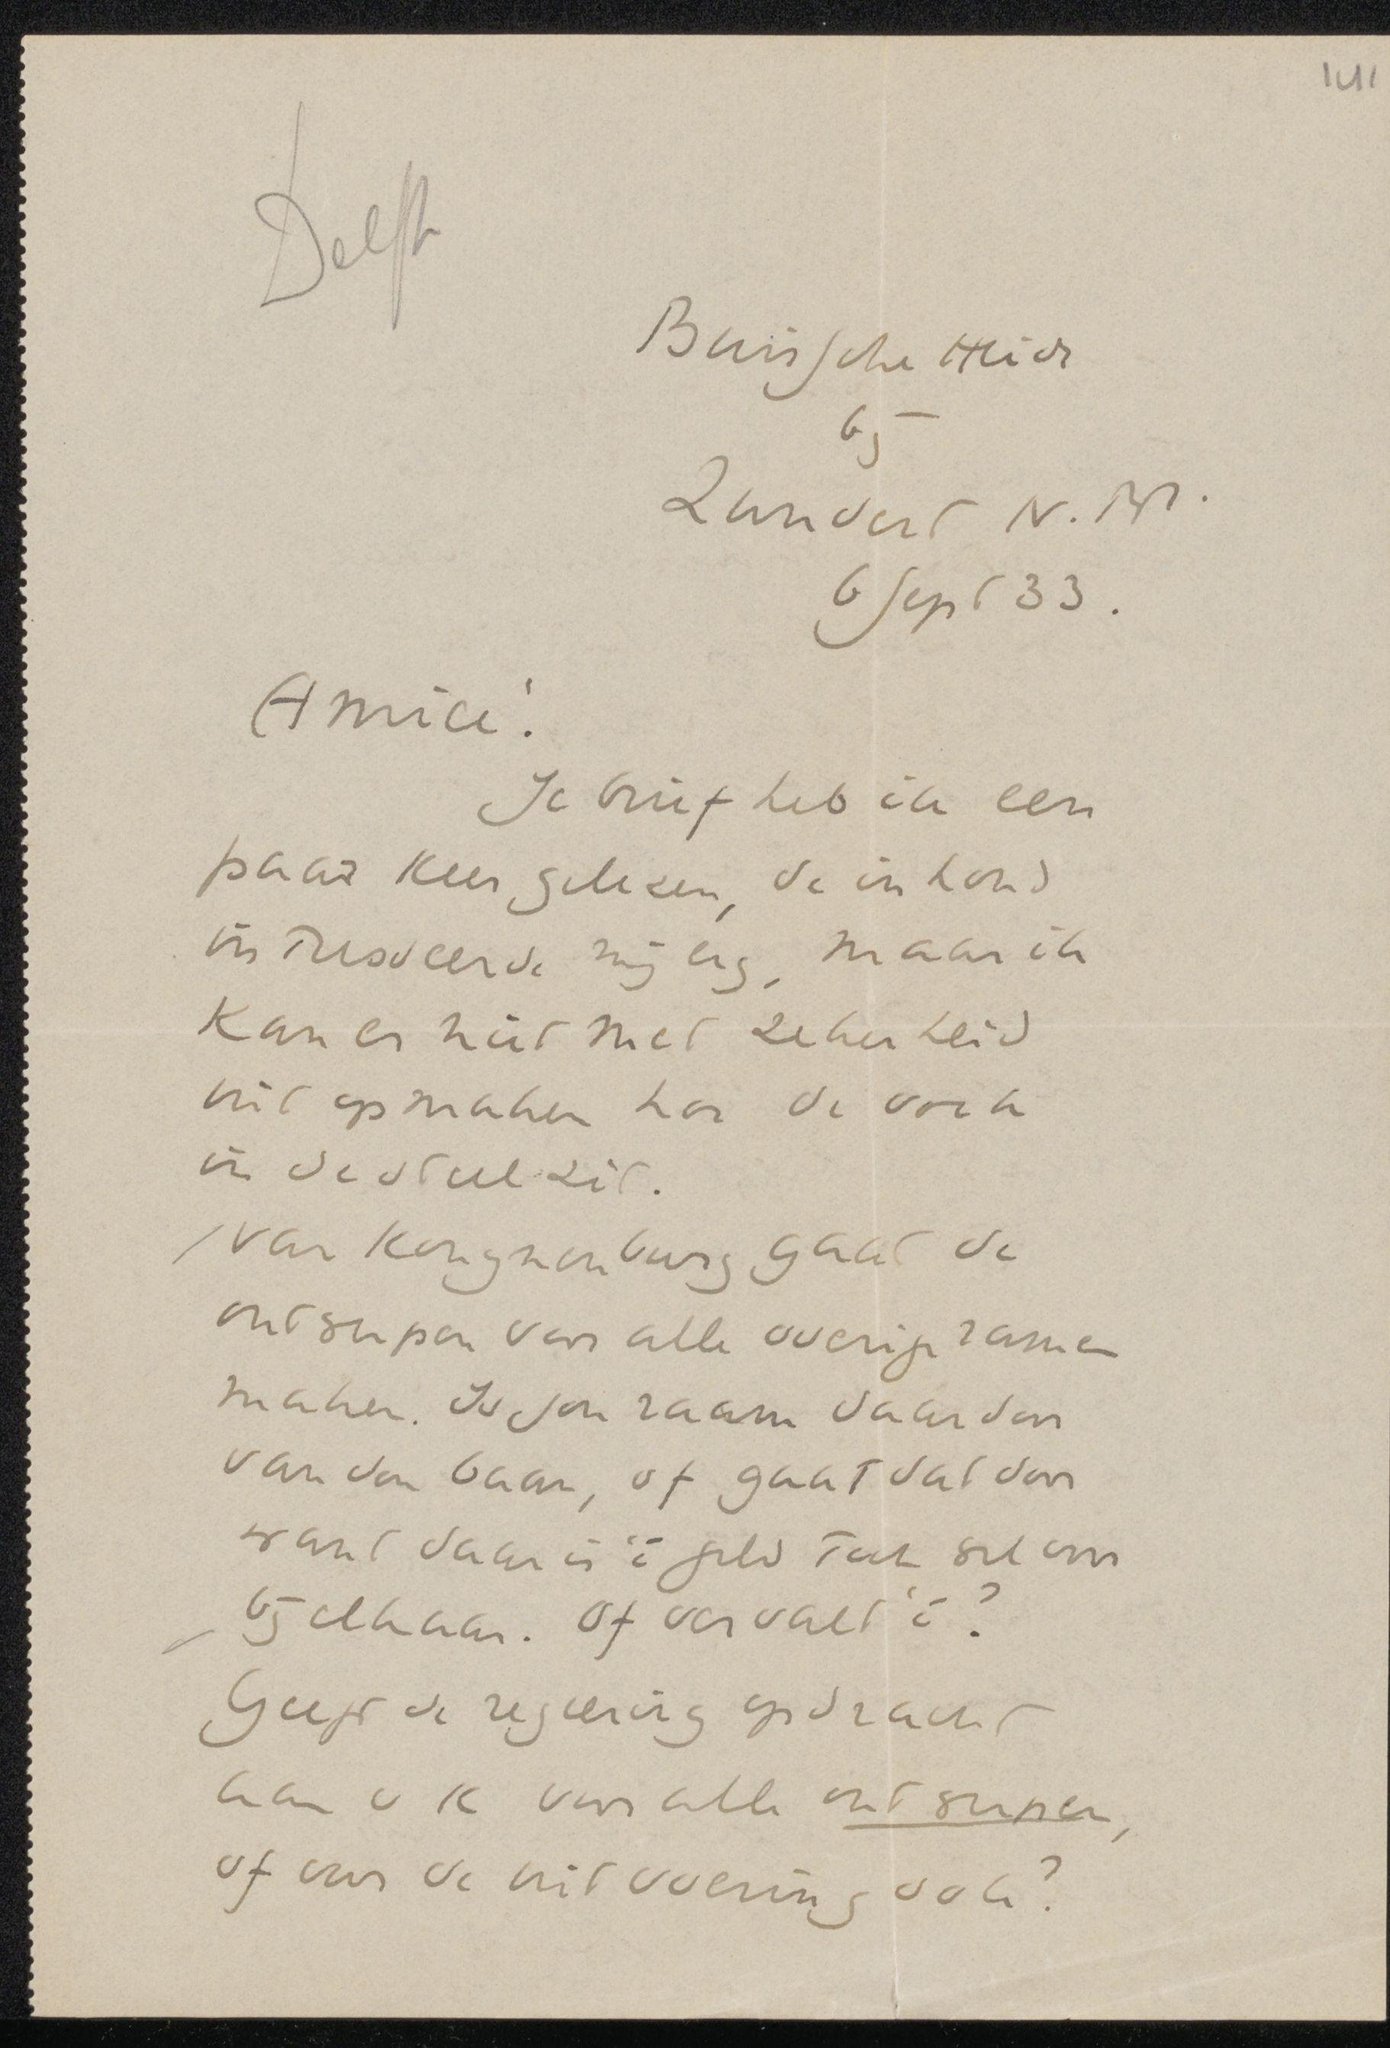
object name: letter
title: Brief aan Willem Bogtman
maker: richard nicolaüs roland holst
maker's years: 1868-1938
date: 1933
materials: ink, paper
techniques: pen, writing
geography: buissche heide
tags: the hague, painter, print maker, draughtsman, willem van konijnenburg, willem bogtman, applied arts, arts and crafts; industrial design